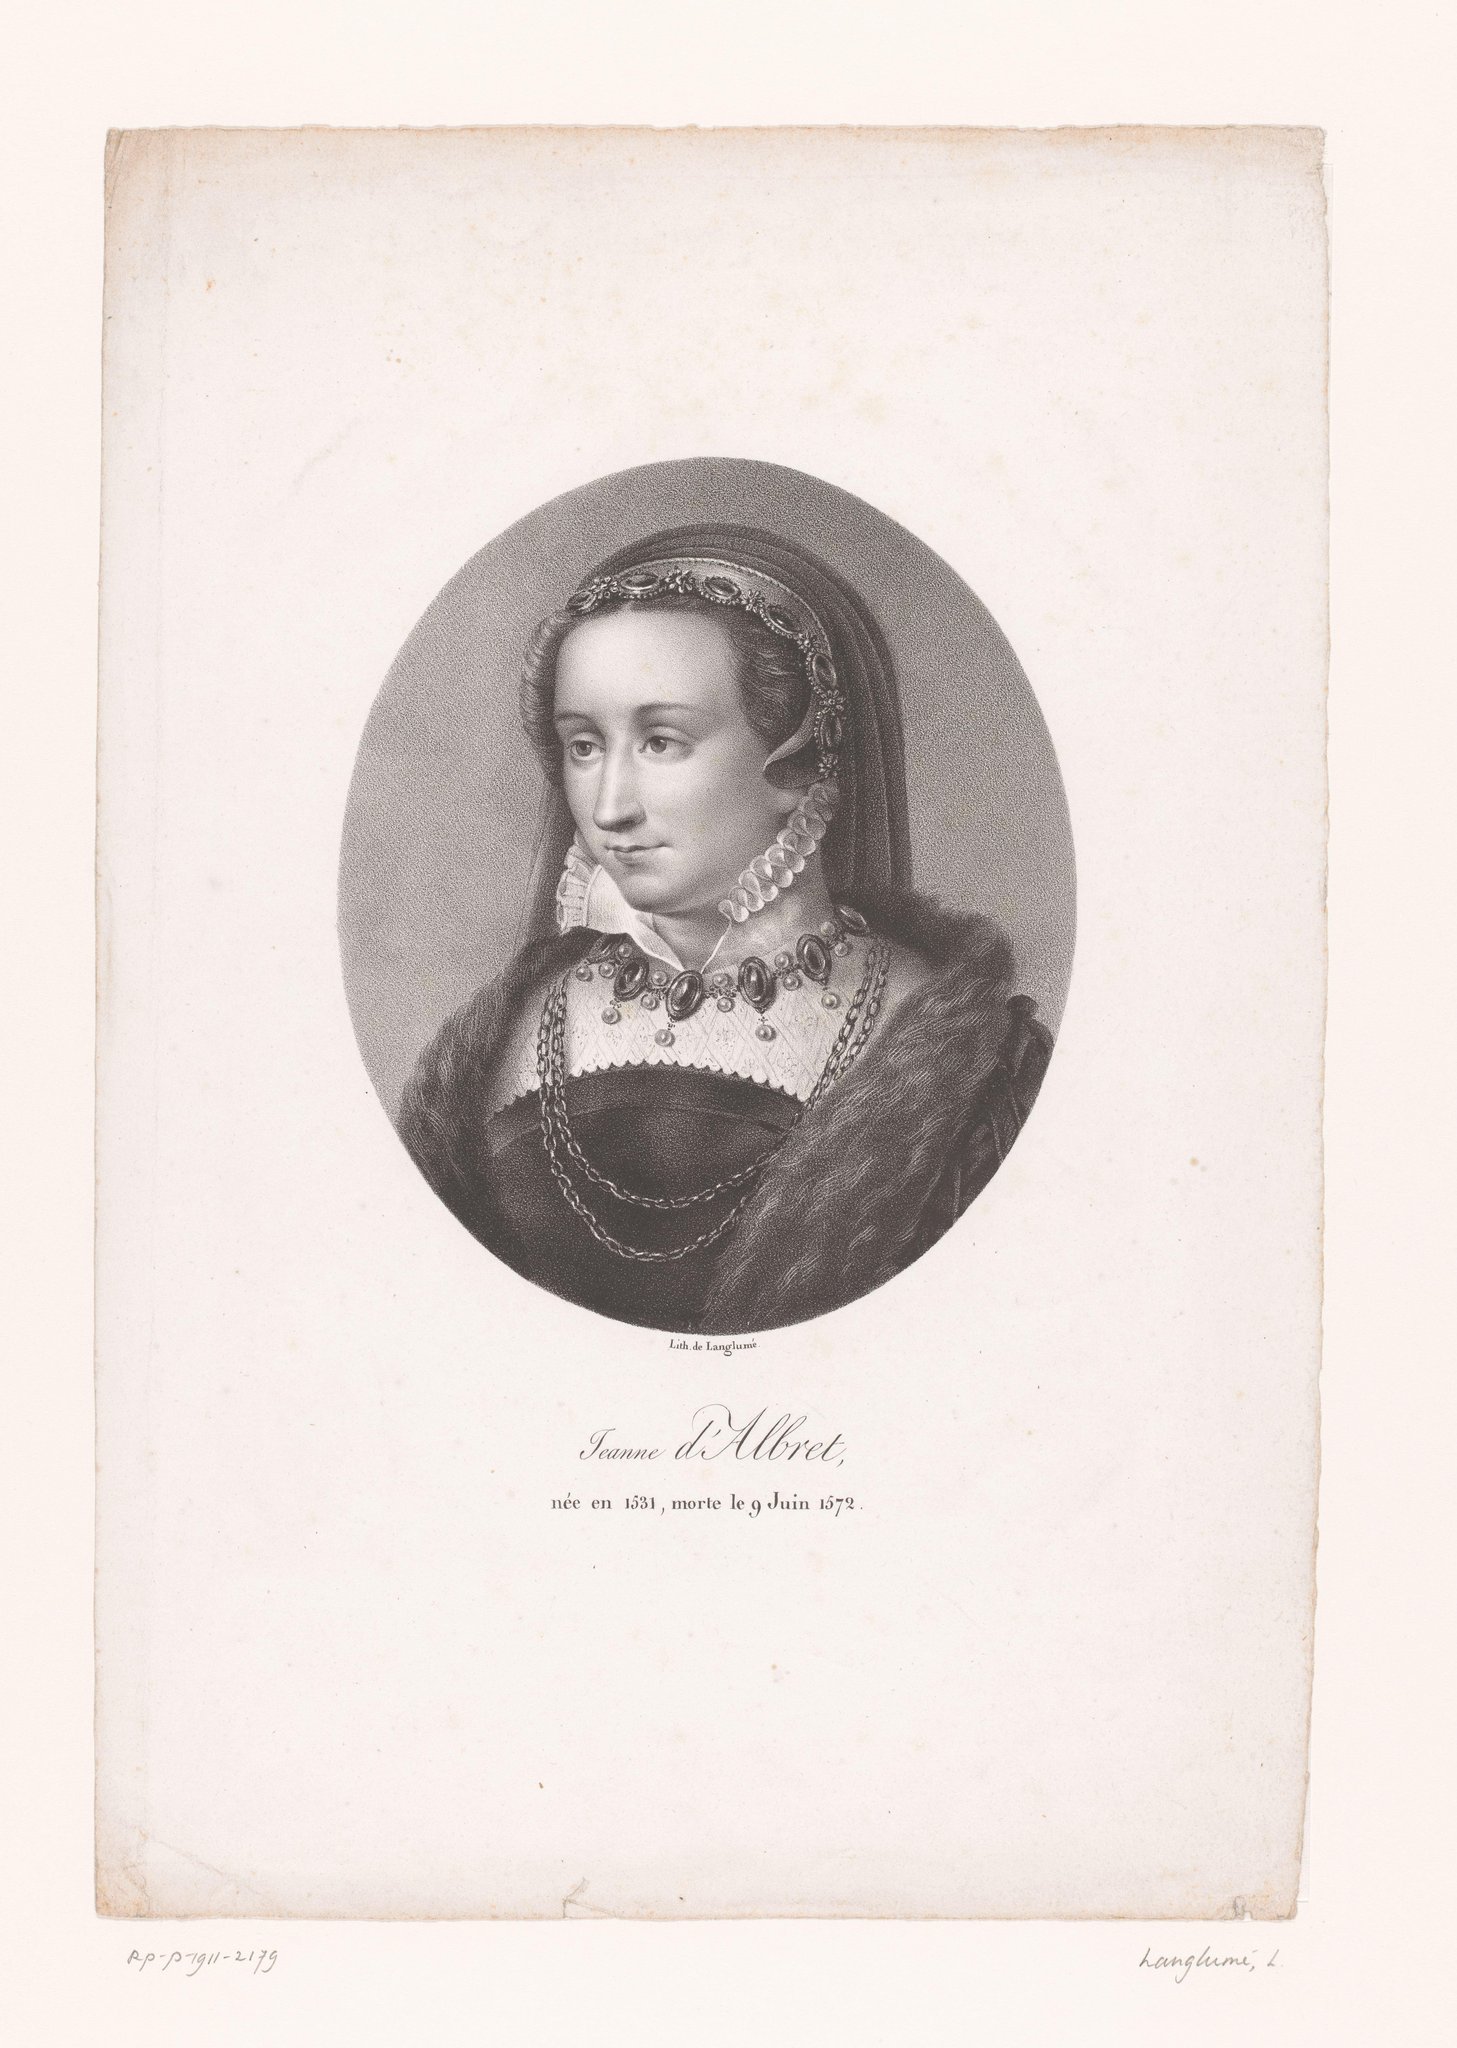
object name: print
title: Jeanne d'Albret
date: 1820-1830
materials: paper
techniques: lithograph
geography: paris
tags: paris, historical persons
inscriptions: collector's mark: Lugt 2228a